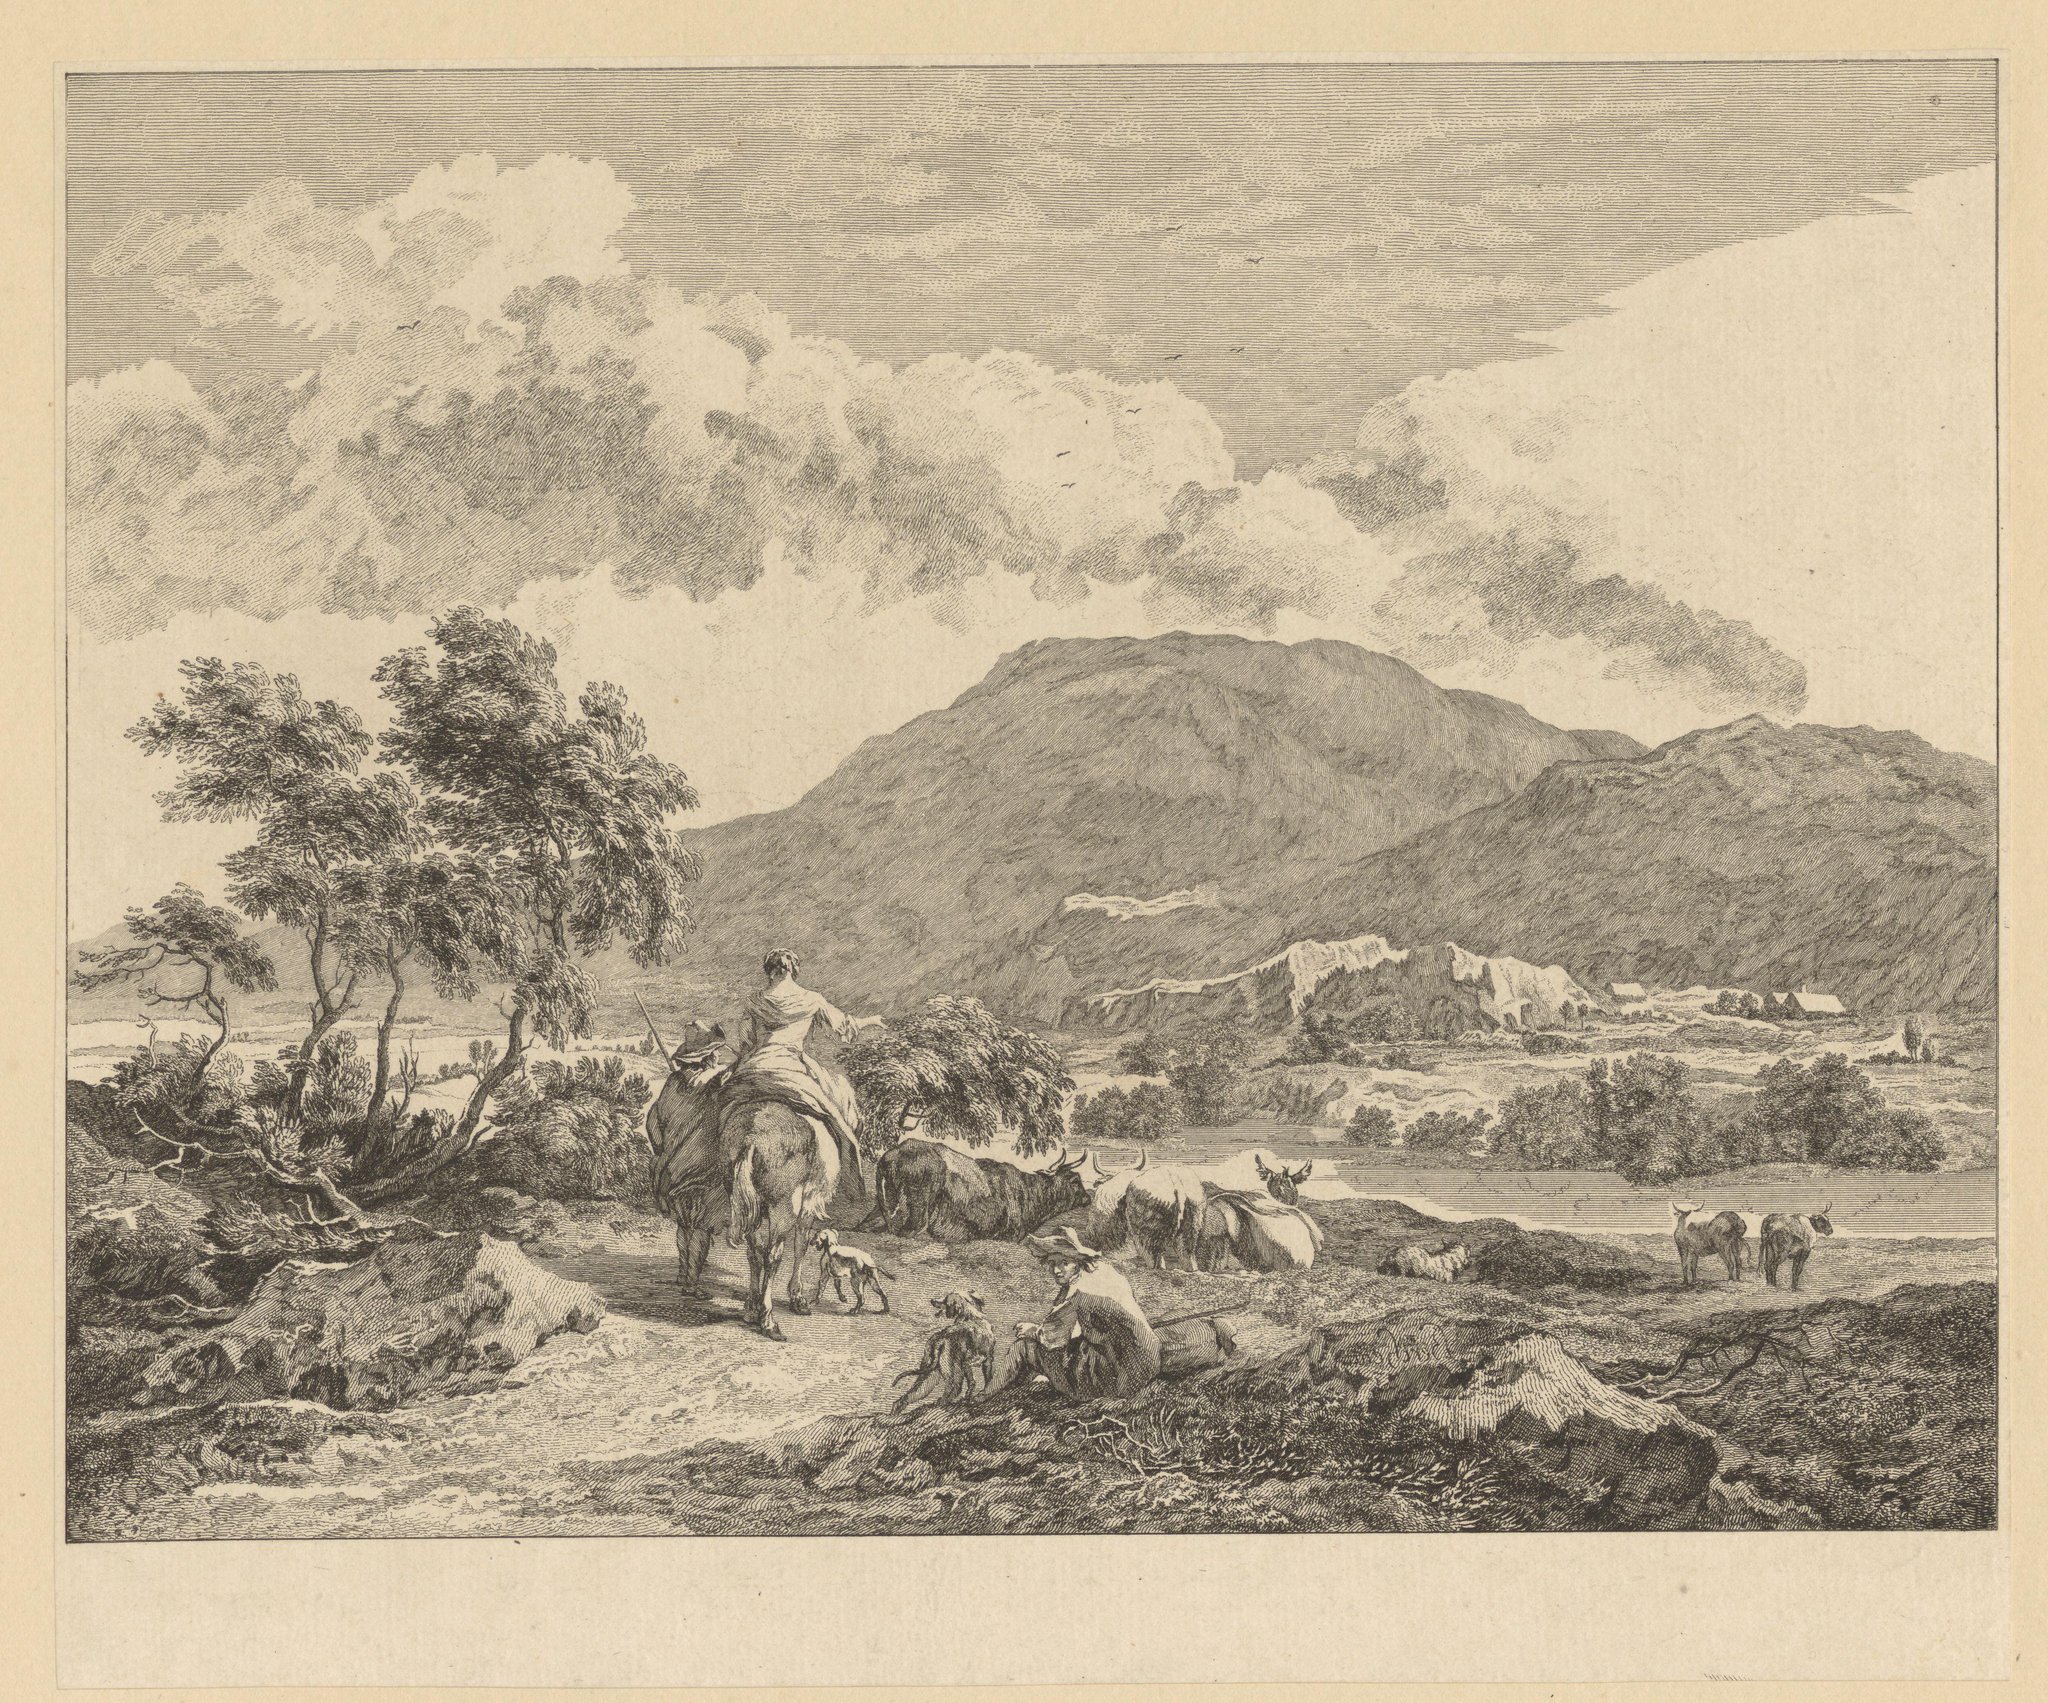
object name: print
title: Les Voyageurs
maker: thomas major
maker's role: print maker, publisher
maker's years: 1714-1799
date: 1748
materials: paper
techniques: etching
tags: herding, herdsman, herdswoman, shepherd, shepherdess, cowherd, etc., (traveller) resting in the open air, low hill country (+ landscape with figures, staffage)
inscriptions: collector's mark: Lugt 240